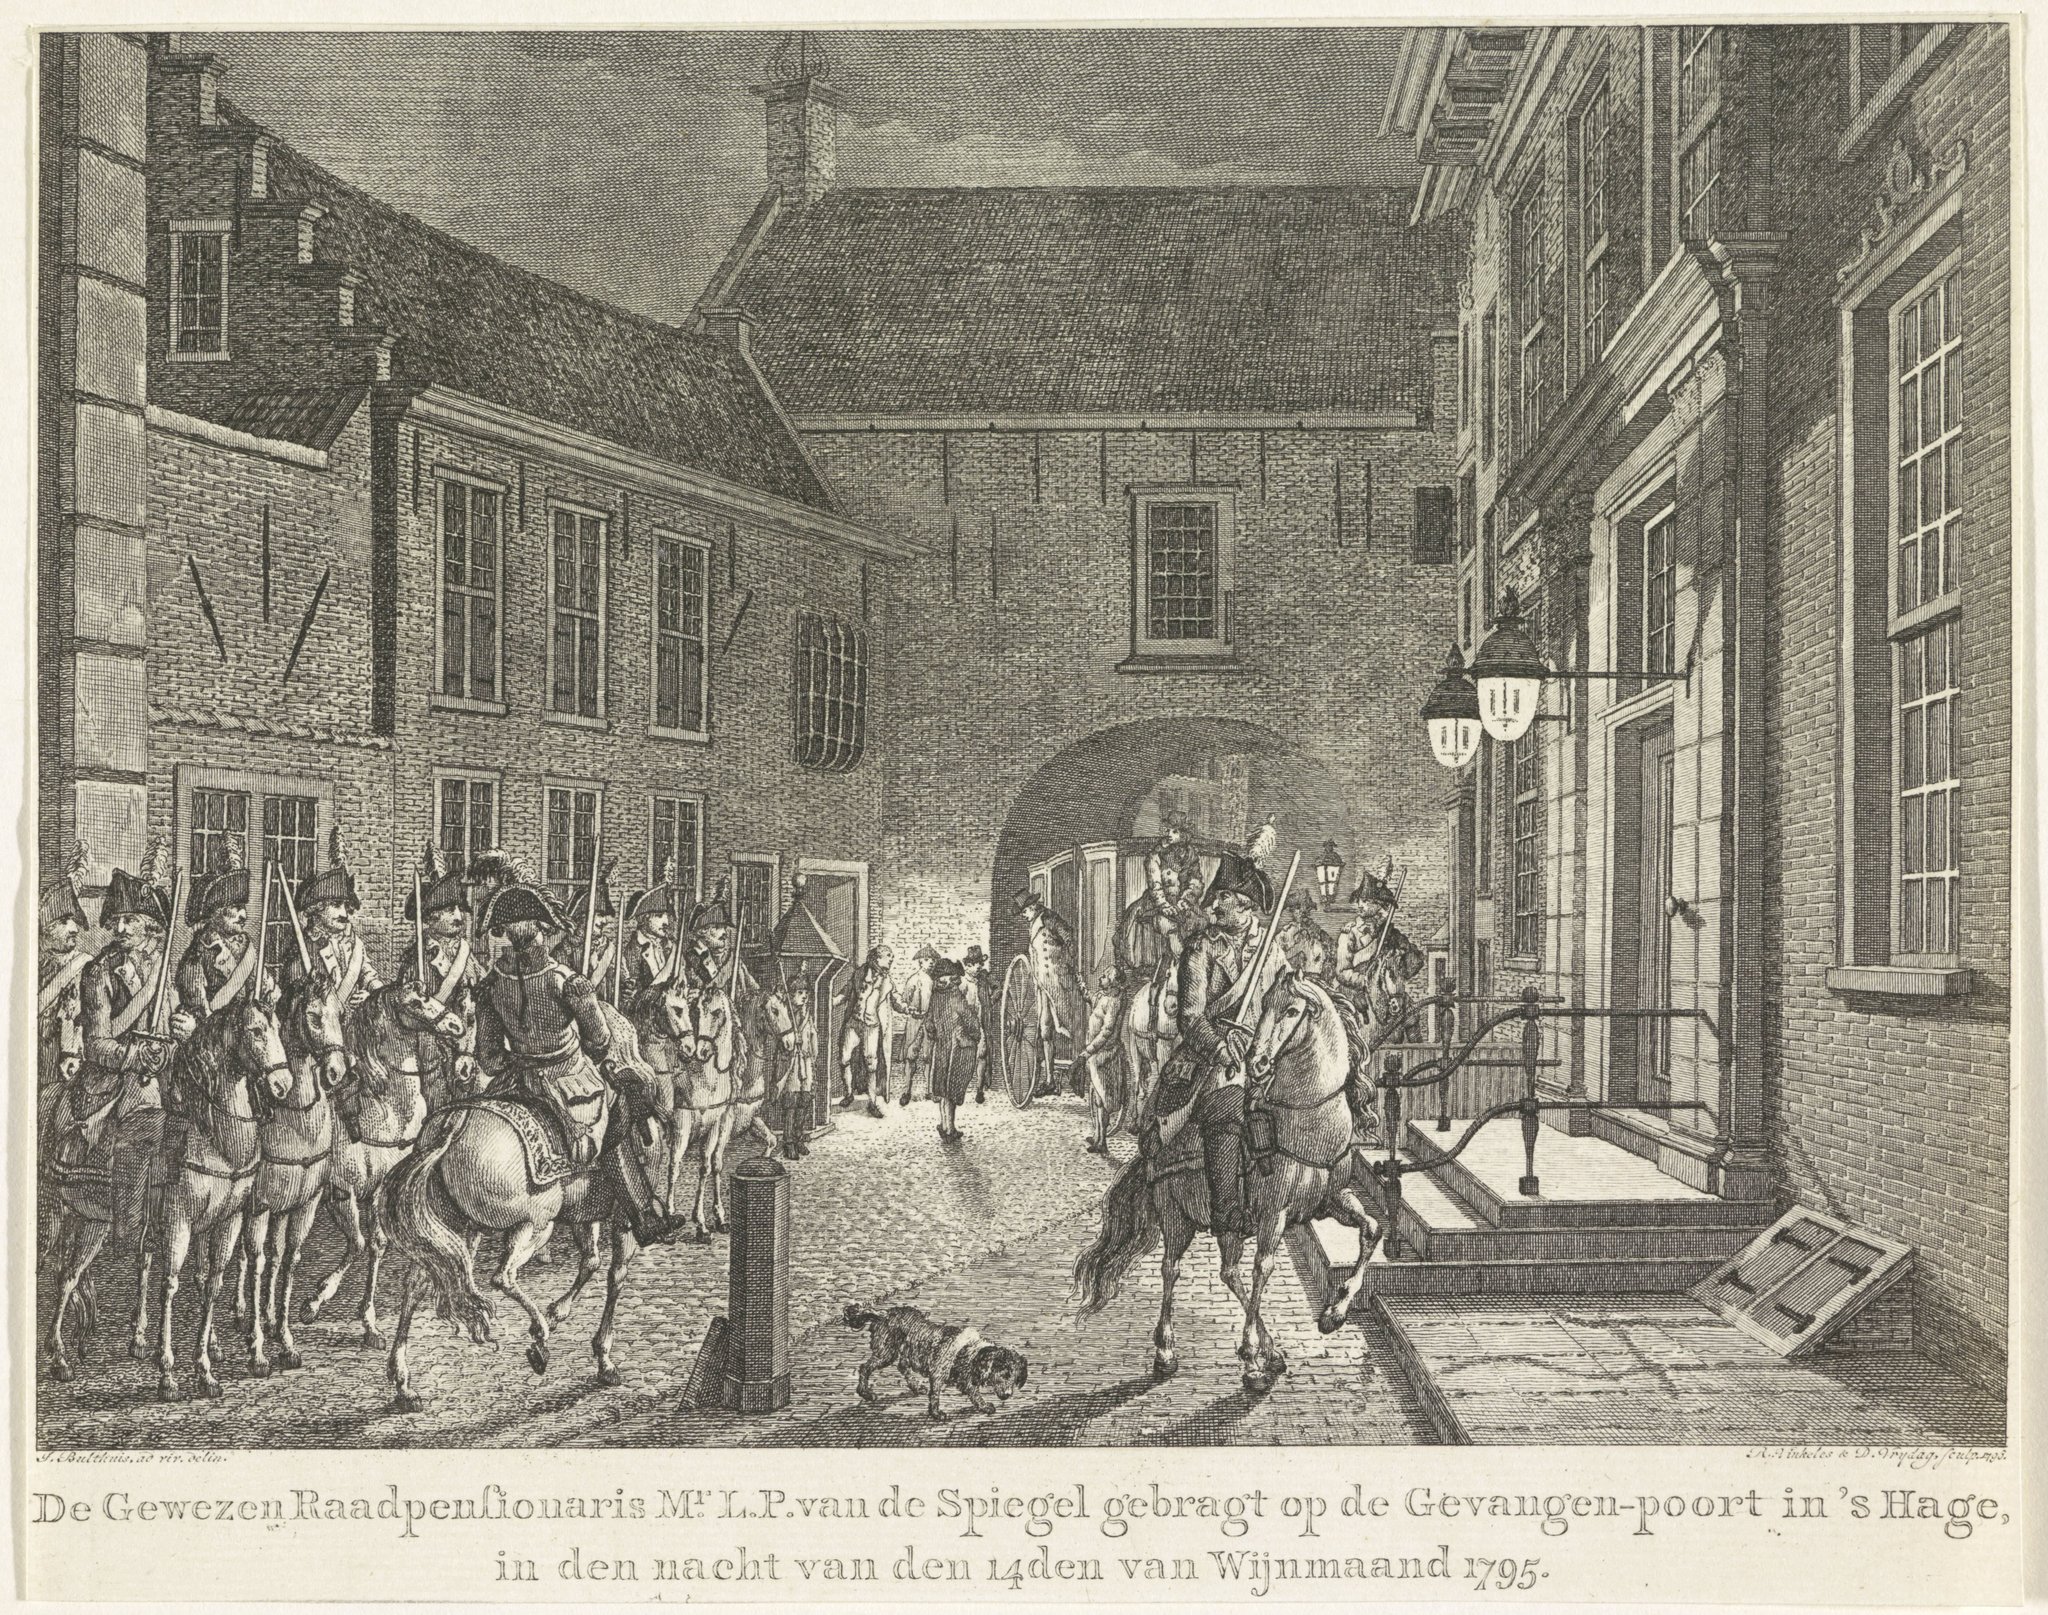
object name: print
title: L.P. van de Spiegel naar de Gevangenpoort gebracht, 1795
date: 1796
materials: paper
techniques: engraving, etching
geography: netherlands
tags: transport (of arrested person), arrest (of criminal)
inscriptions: collector's mark: Lugt 2228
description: De voormalige raadspensionaris Laurens Pieter van de Spiegel wordt 's avonds naar de Gevangenpoort te Den Haag overgebracht, 14 oktober 1795. Spiegel stapt uit het rijtuig, op de voorgrond links een escorte soldaten te paard.